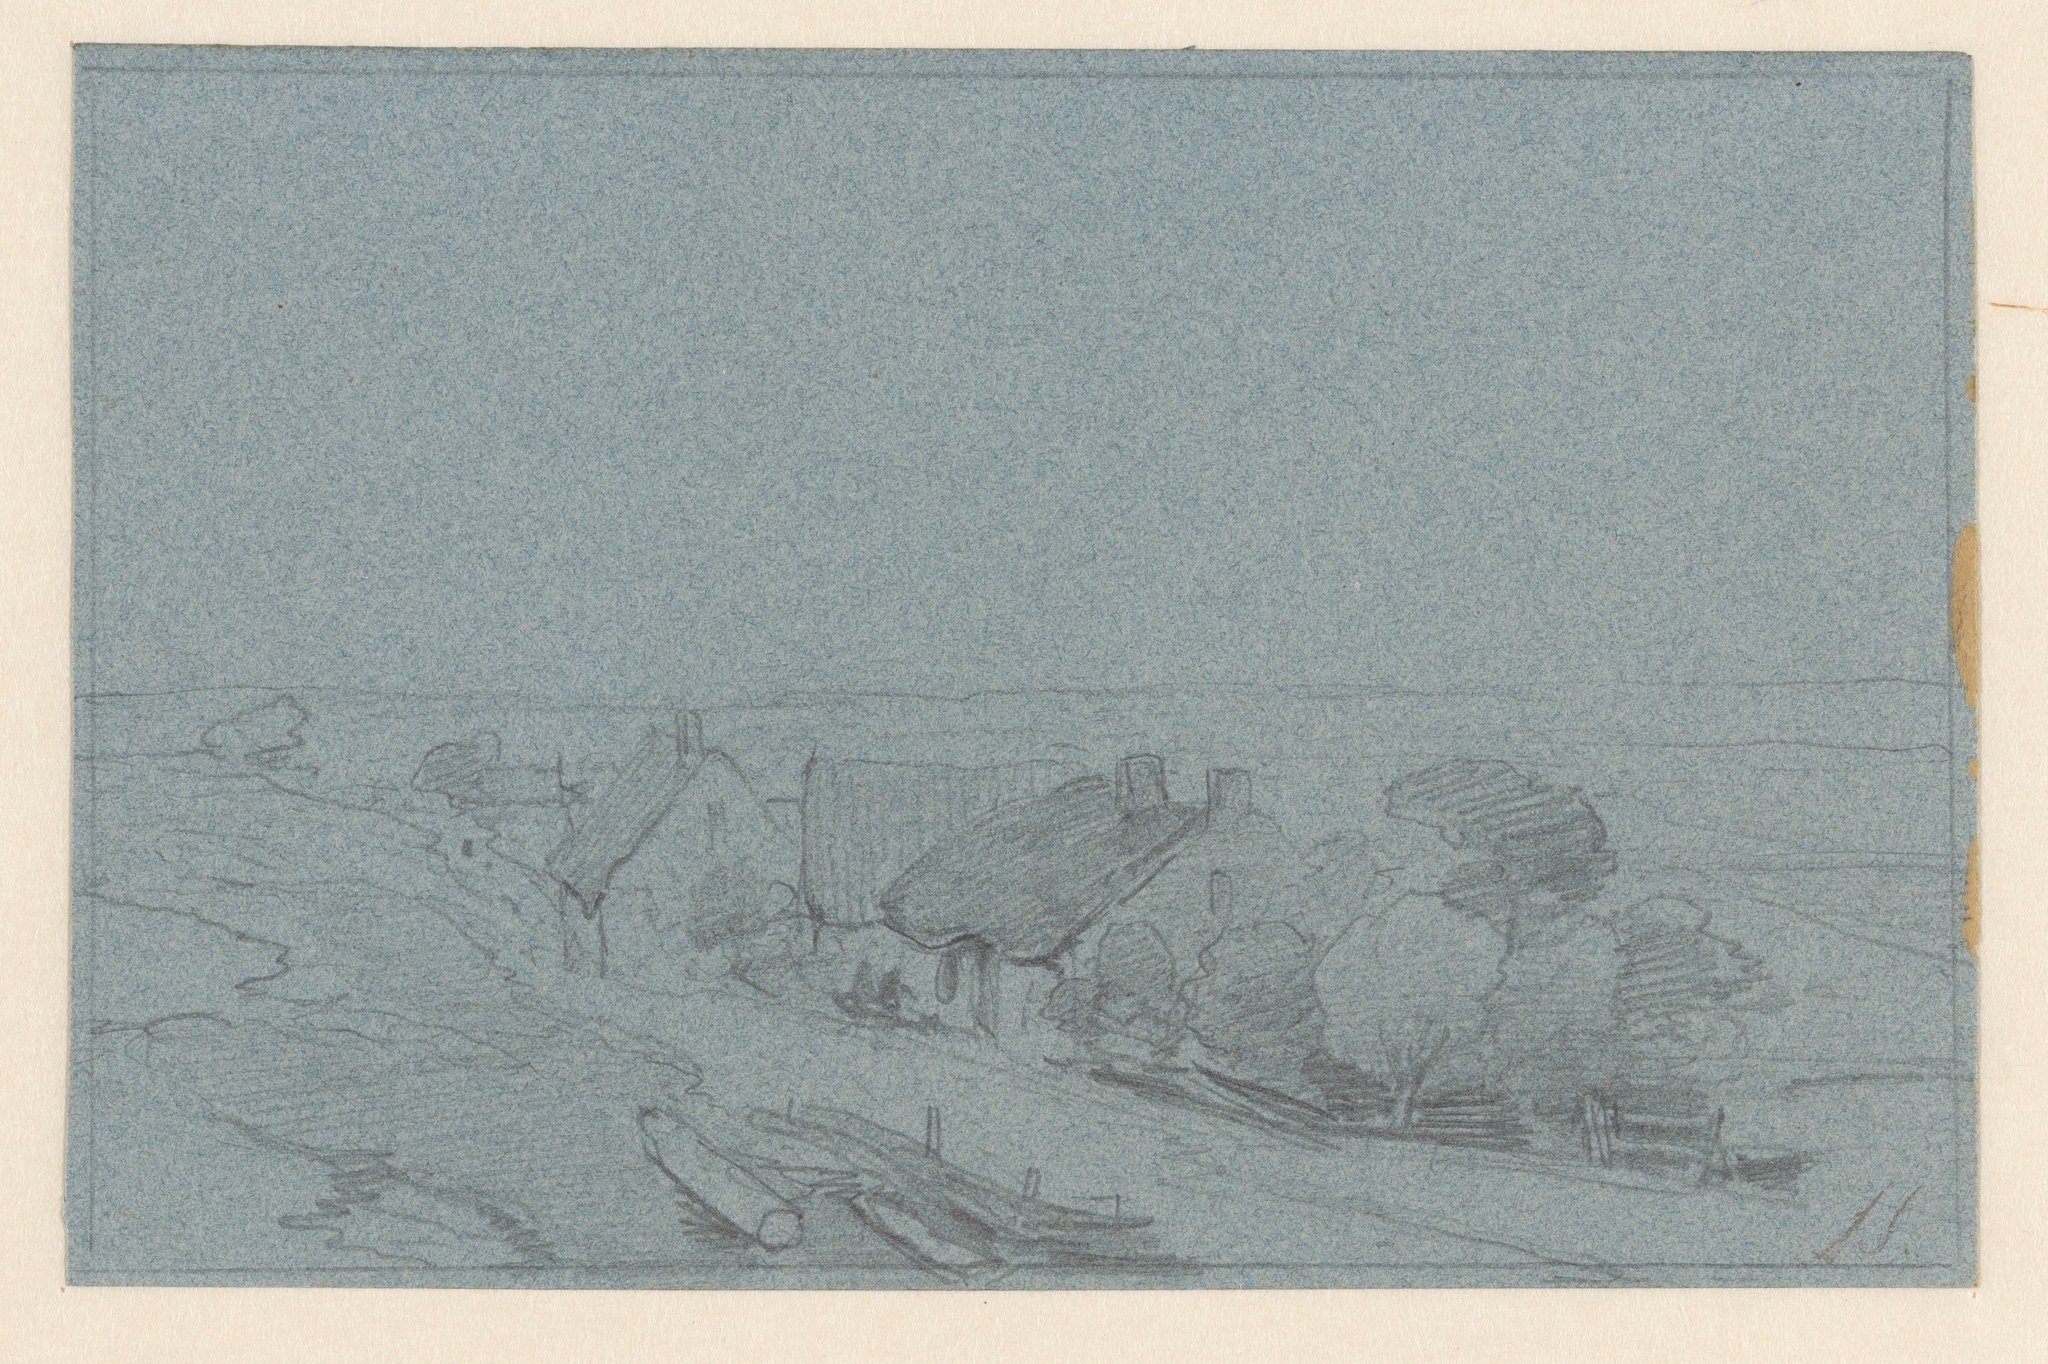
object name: drawing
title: Landschap met enkele huizen en bomen van een heuvel gezien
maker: andreas schelfhout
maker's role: draughtsman, painter, print maker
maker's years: 1787-1870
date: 1797-1870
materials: paper, pencil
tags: farm or solitary house in landscape